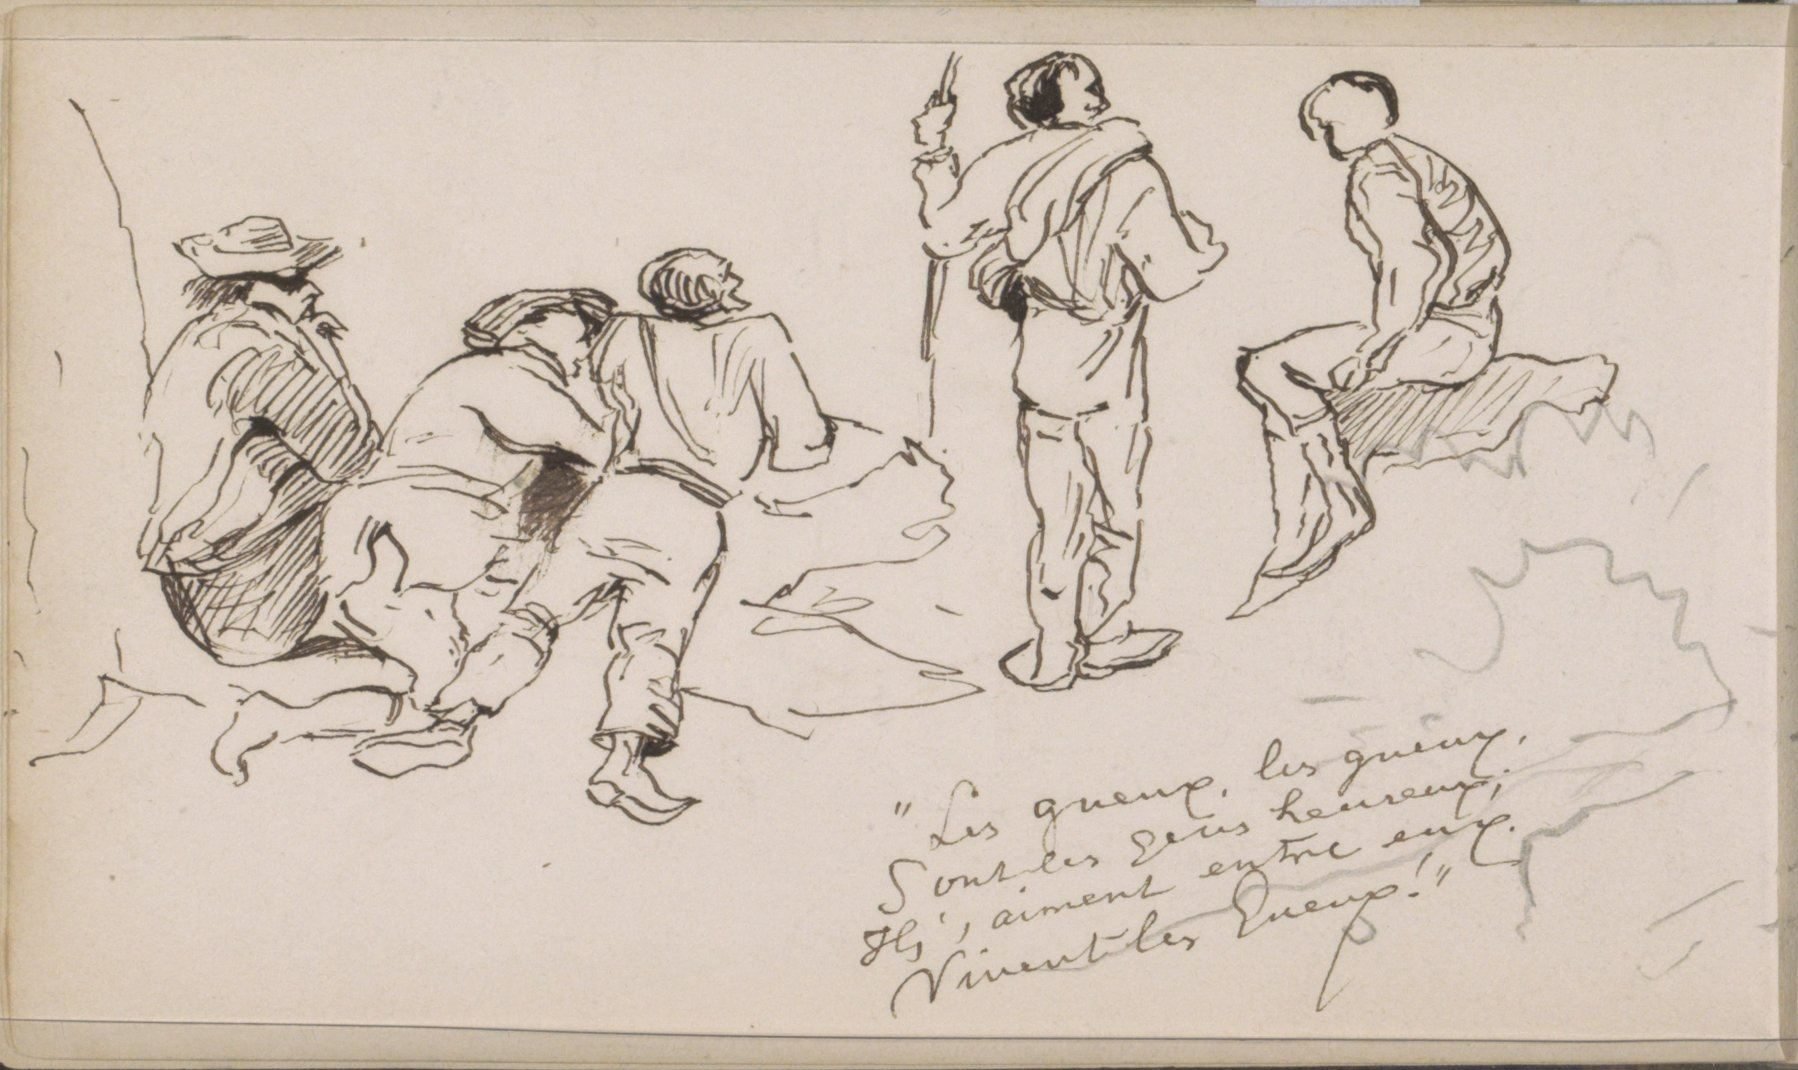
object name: sketchbook leaf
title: Mannen rondom een vuurkorf bij een boom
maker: johannes tavenraat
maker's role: draughtsman, painter, print maker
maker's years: 1809-1881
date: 1873-1876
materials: ink, paper, pencil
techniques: pen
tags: trees, woodgathering, woodgatherer, adult man, camp-fire; watch-fire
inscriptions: annotation: ‘licht achter’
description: Eén man draagt een bos sprokkelhout op de rug. Blad 13 verso uit een schetsboek met 46 bladen.